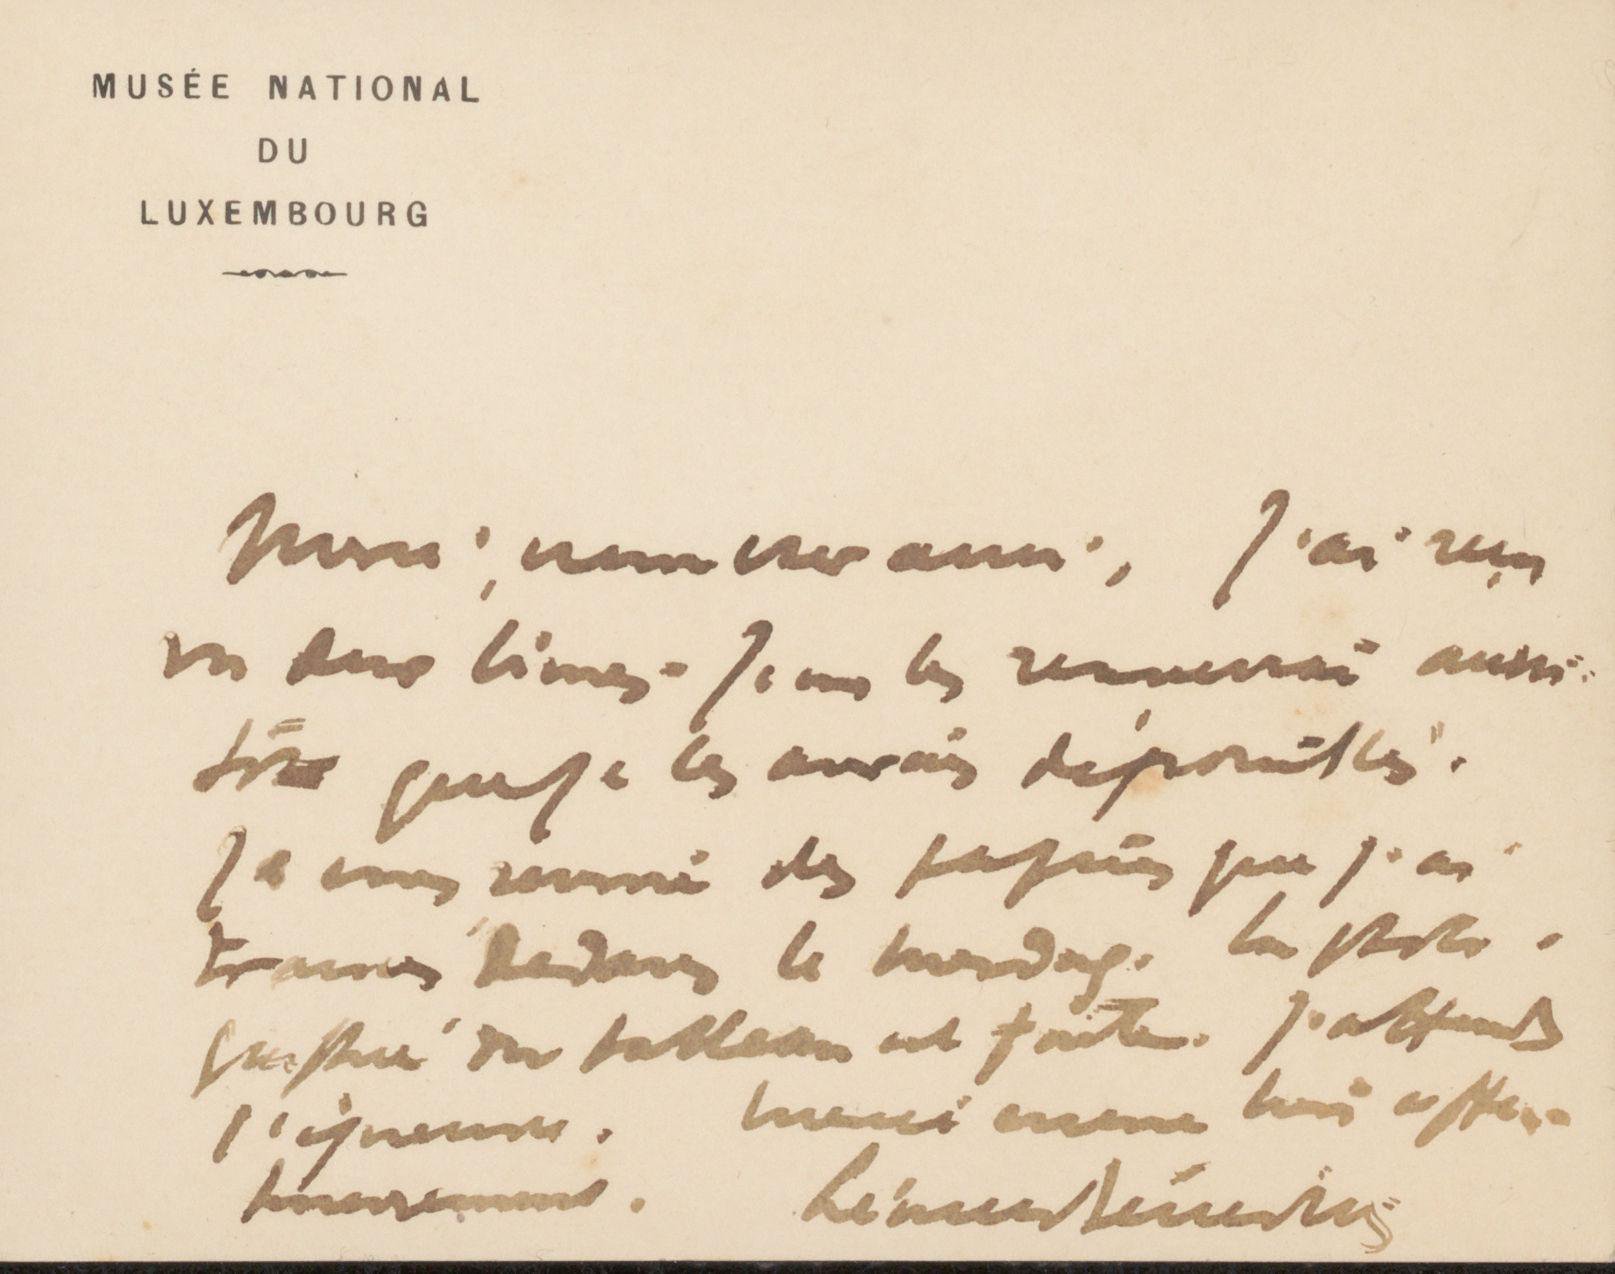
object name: letter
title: Brief aan Philip Zilcken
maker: léonce bénédite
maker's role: conservator, museumdirecteur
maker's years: 1856-1925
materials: cardboard, ink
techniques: pen, printing, writing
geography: paris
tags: the hague, painter, philip zilcken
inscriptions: collector's mark: ‘RPK’